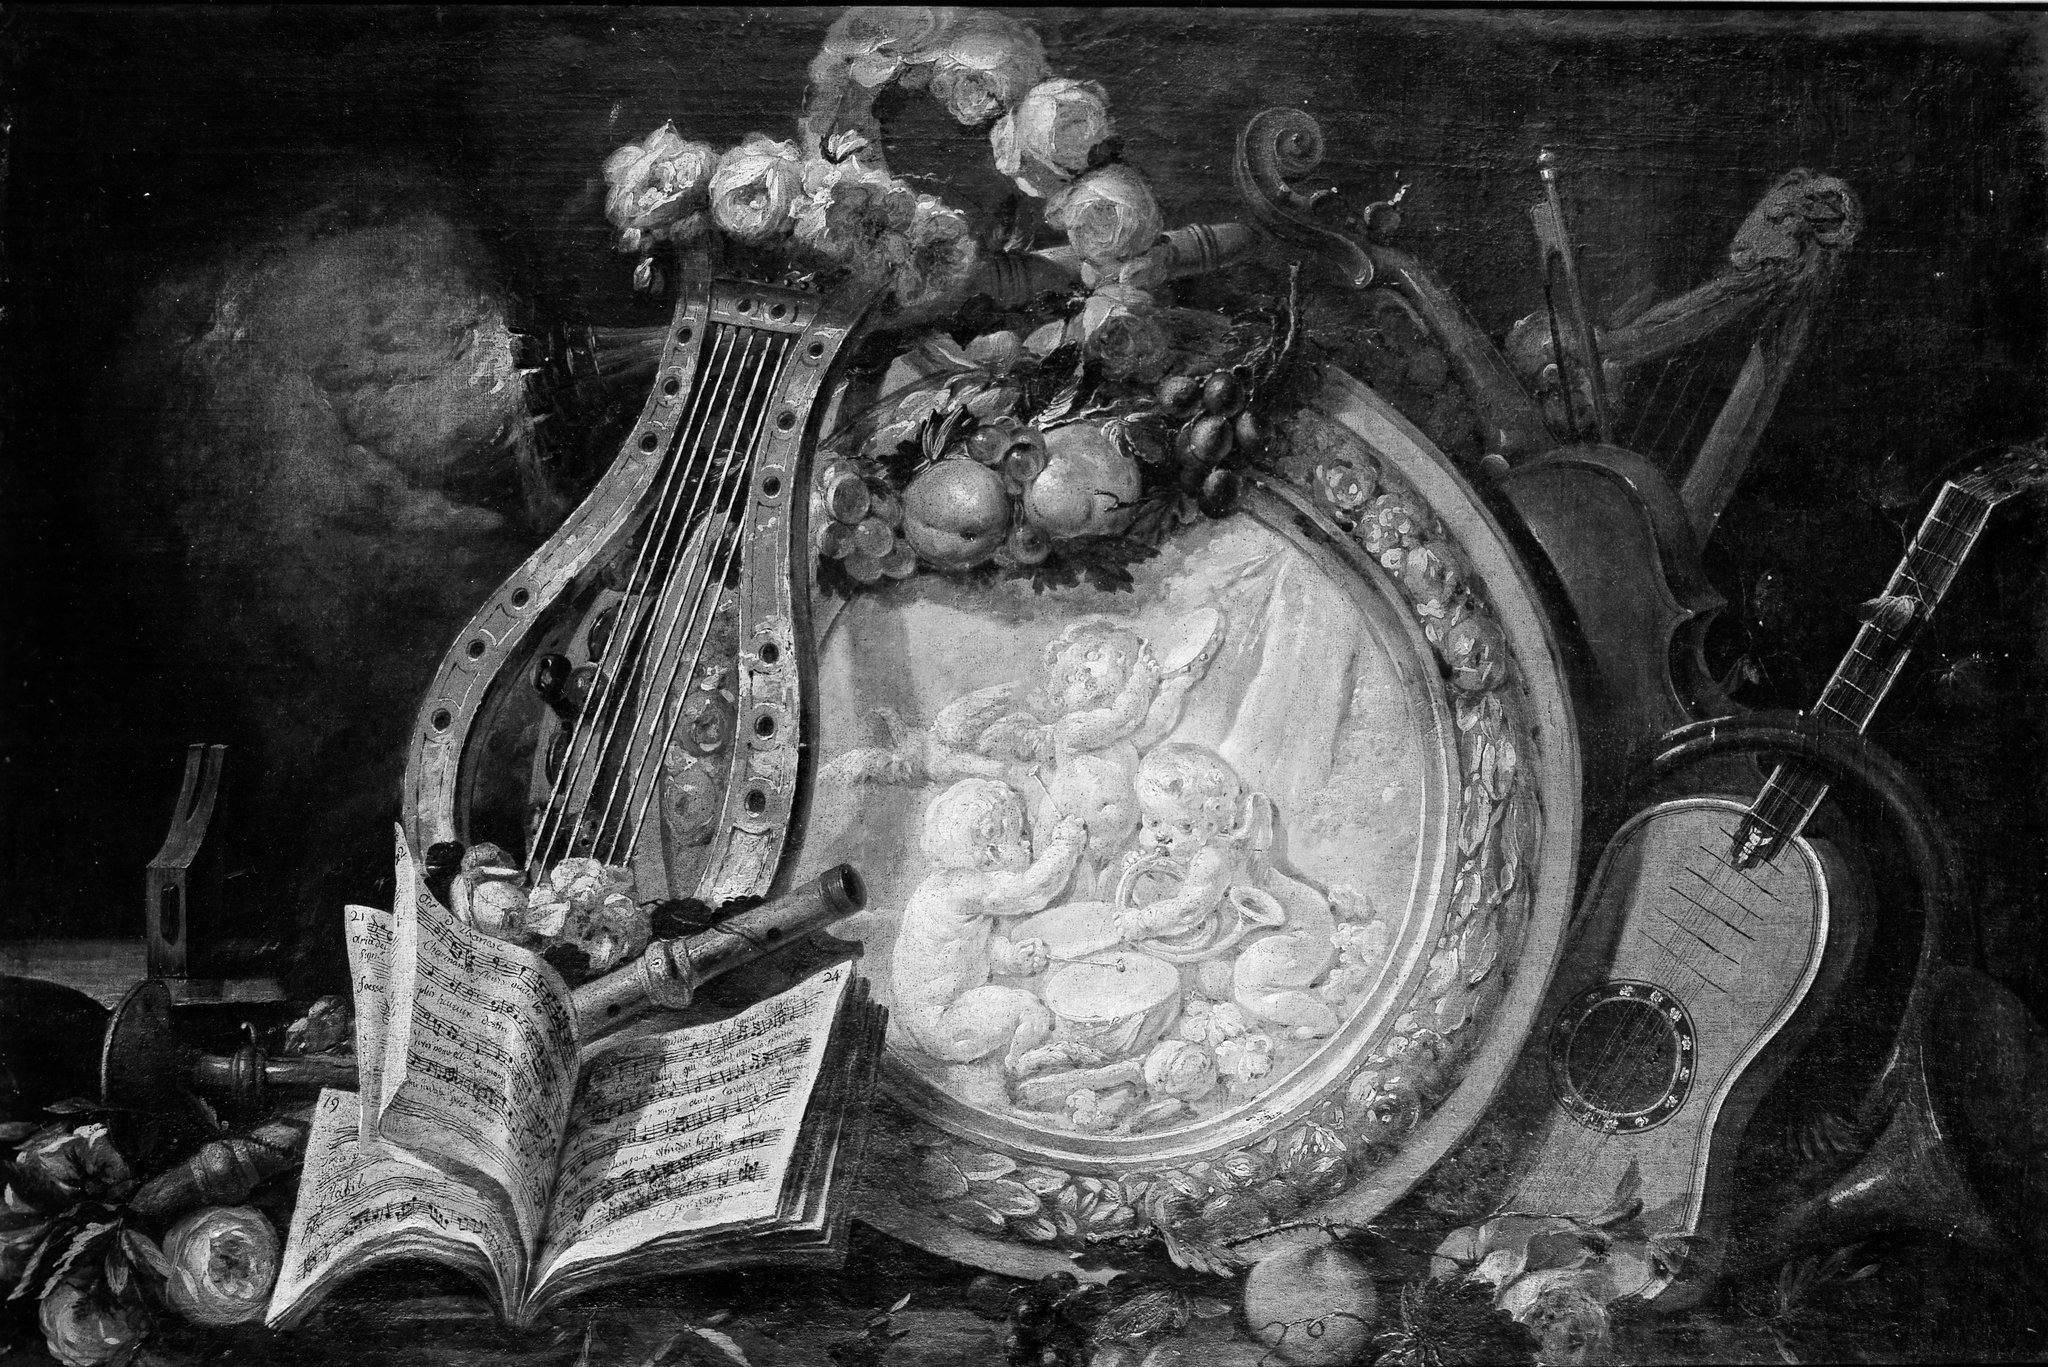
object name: overdoor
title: Putti Musicians in a Medallion, Surrounded by Musical Attributes, Flowers, and Fruit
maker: french painter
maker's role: artist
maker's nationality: french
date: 1701-1800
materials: canvas, oil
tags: musical instruments,fruit,flowers,musicians